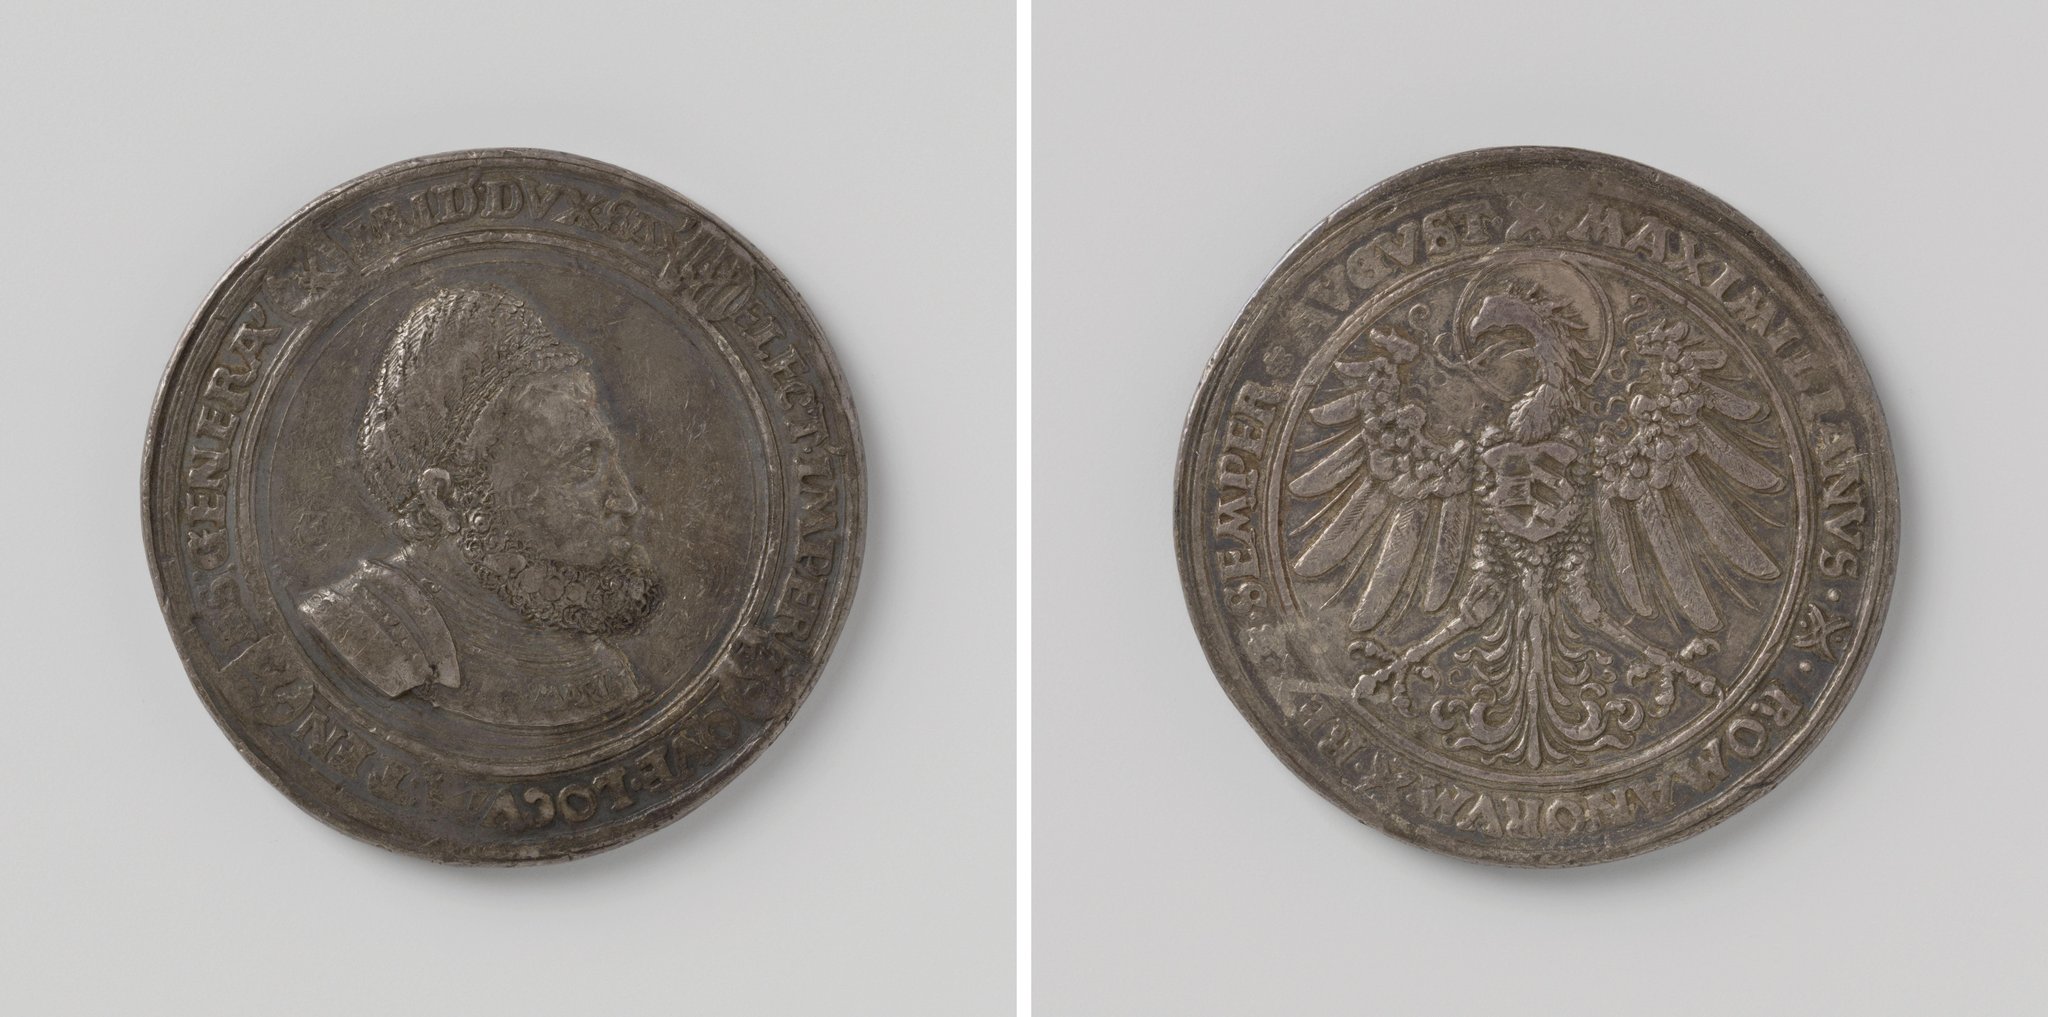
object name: dubbele guldengroschen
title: Dubbele schautaler (dubbele guldengroschen; dubbele (locumtenens) taler) op naam van Frederik III de Wijze van Saksen, door Maximiliaan aangesteld als algemeen stadhouder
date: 1512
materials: silver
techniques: striking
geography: wittenberg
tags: print maker, draughtsman, lucas cranach (i), maximilian i (holy roman emperor)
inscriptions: circumscription: ‘FRID DVX SAX ELECT IMPERI QVE LOCVM TE NES GENERA’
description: Dubbele guldengroschen, locumtenenstaler. Voorzijde: borststuk man binnen rand met omschrift en wapenschilden. Keerzijde: adelaar met wapenschild op borst binnen omschrift